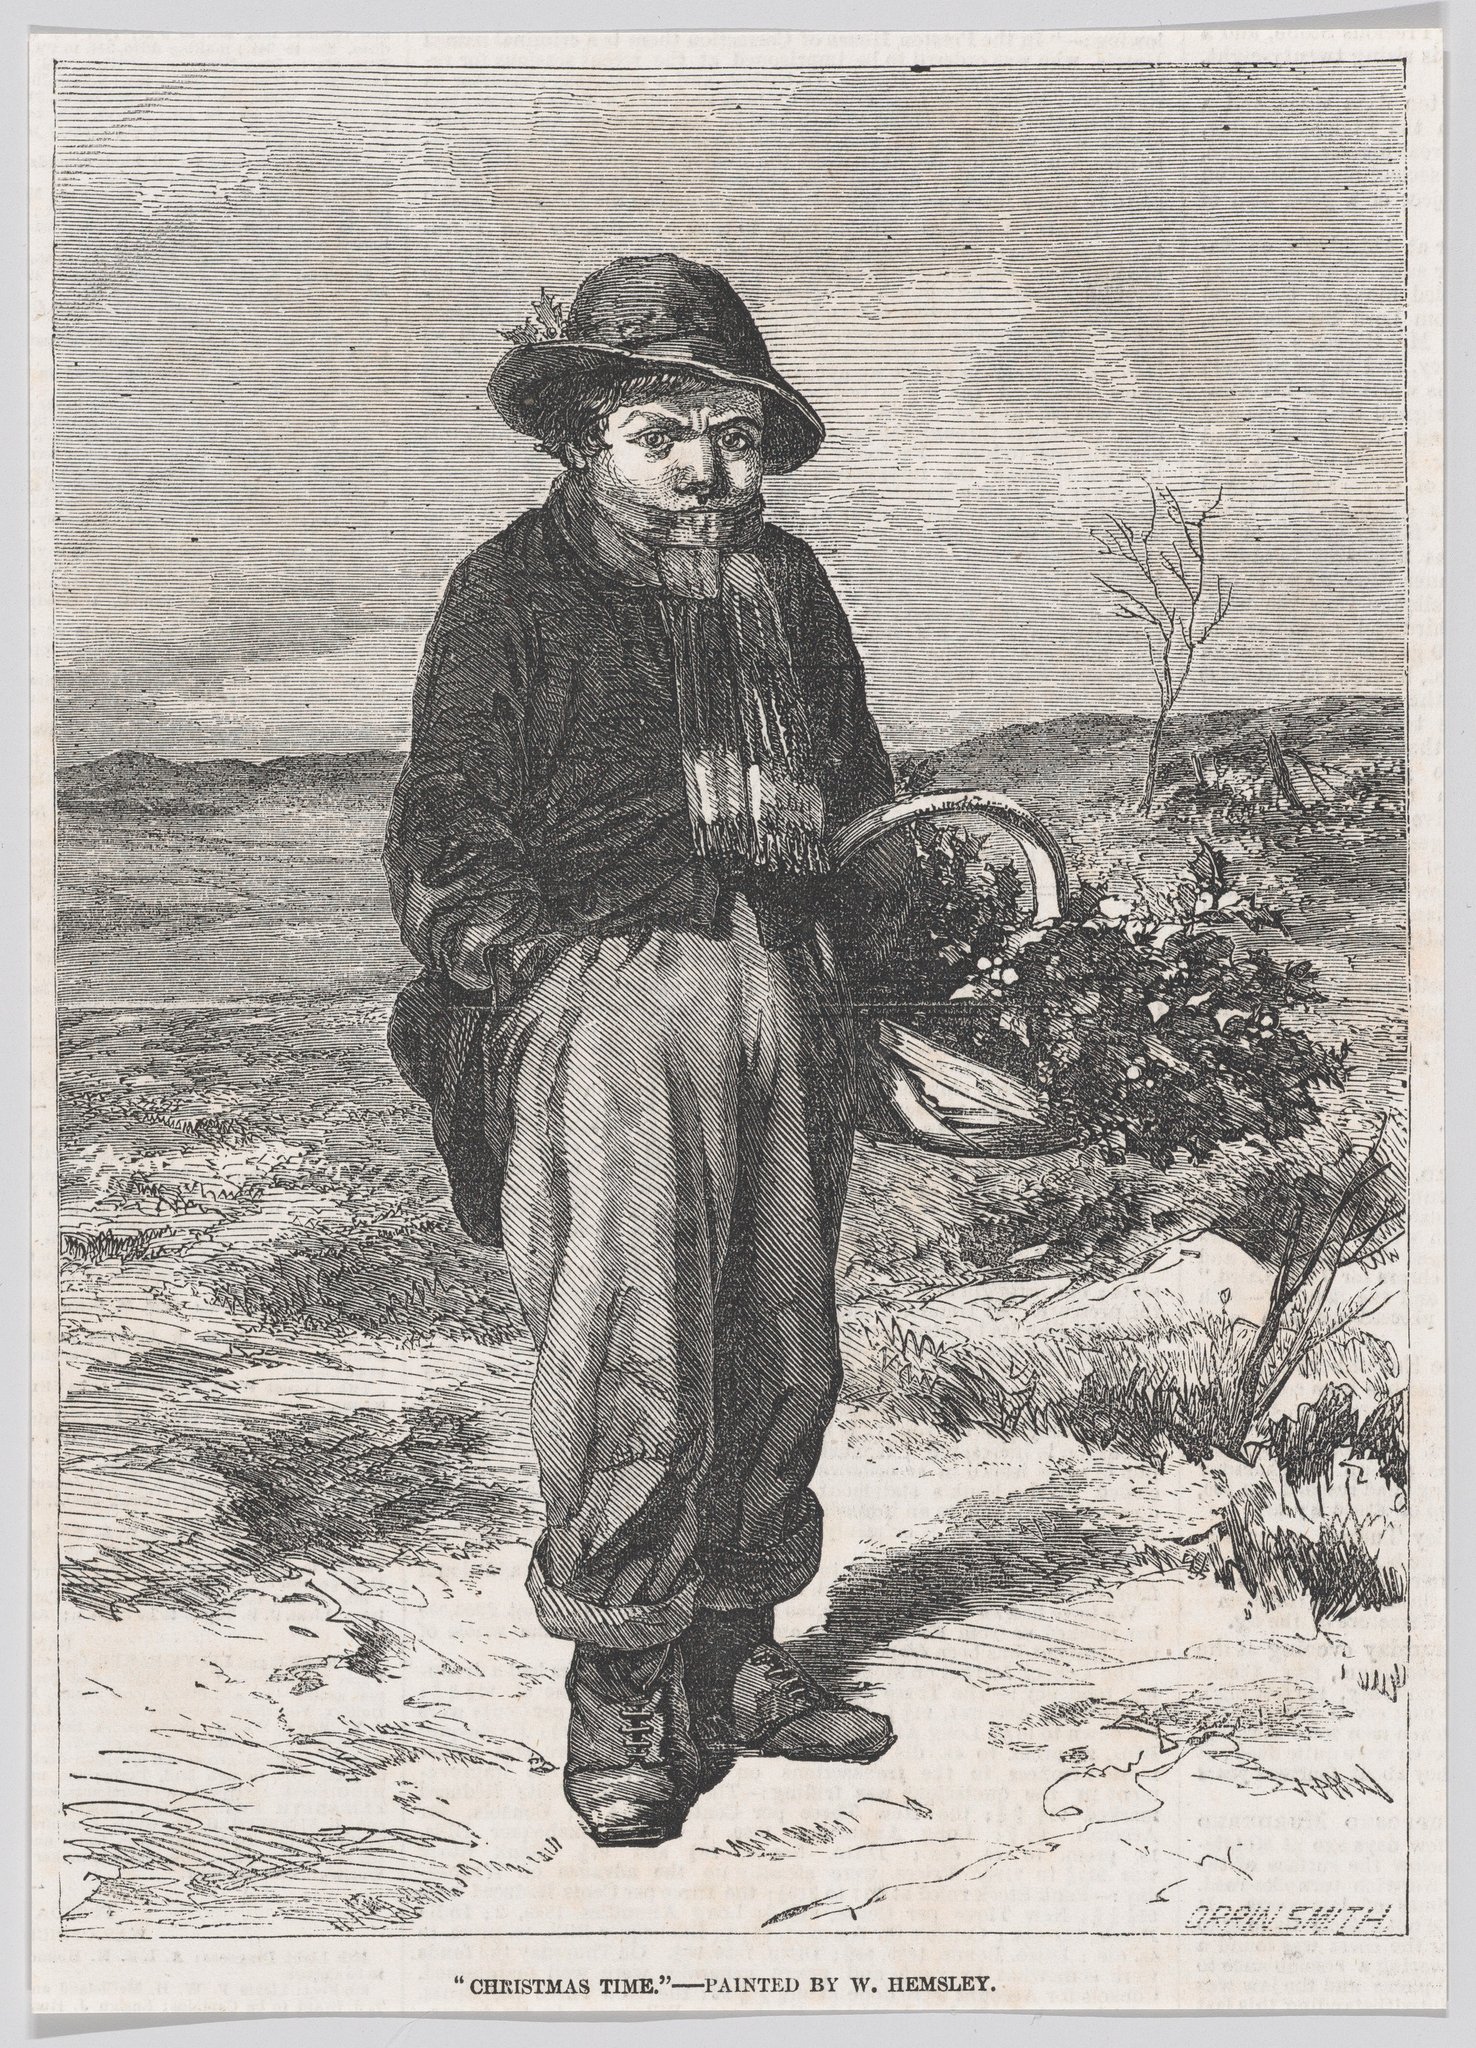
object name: print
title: Christmas Time, from "Illustrated London News"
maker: harvey orrin smith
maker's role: engraver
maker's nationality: british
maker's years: 1847-1870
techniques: engraving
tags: boys